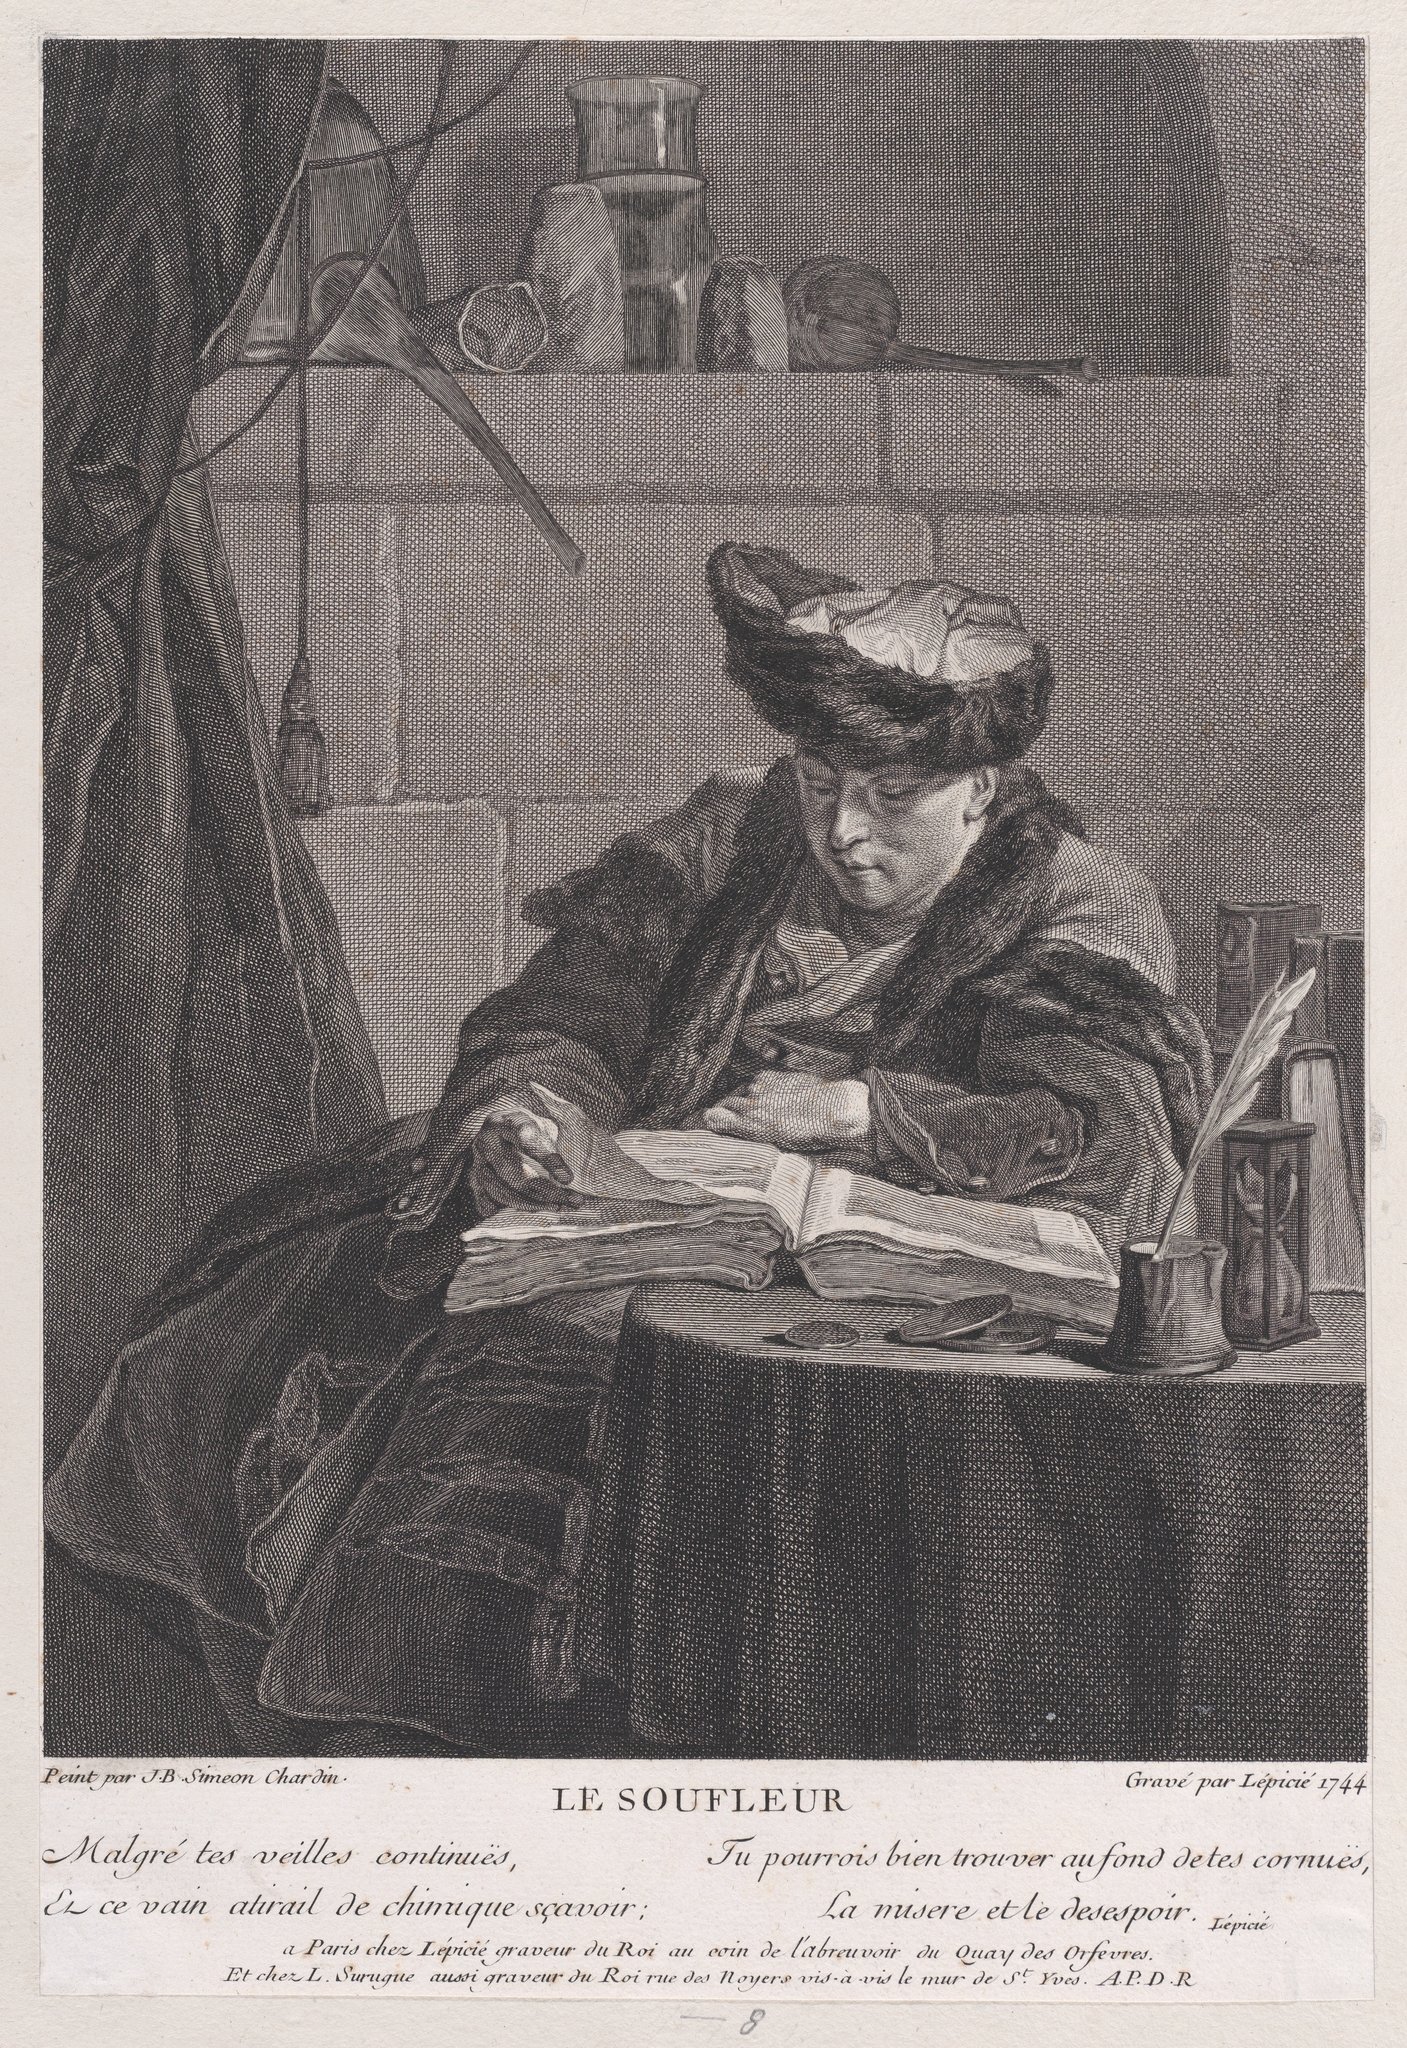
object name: print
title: The Philosopher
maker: bernard lepicié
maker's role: artist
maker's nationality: french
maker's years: 1698-1755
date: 1744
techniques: engraving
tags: men,reading